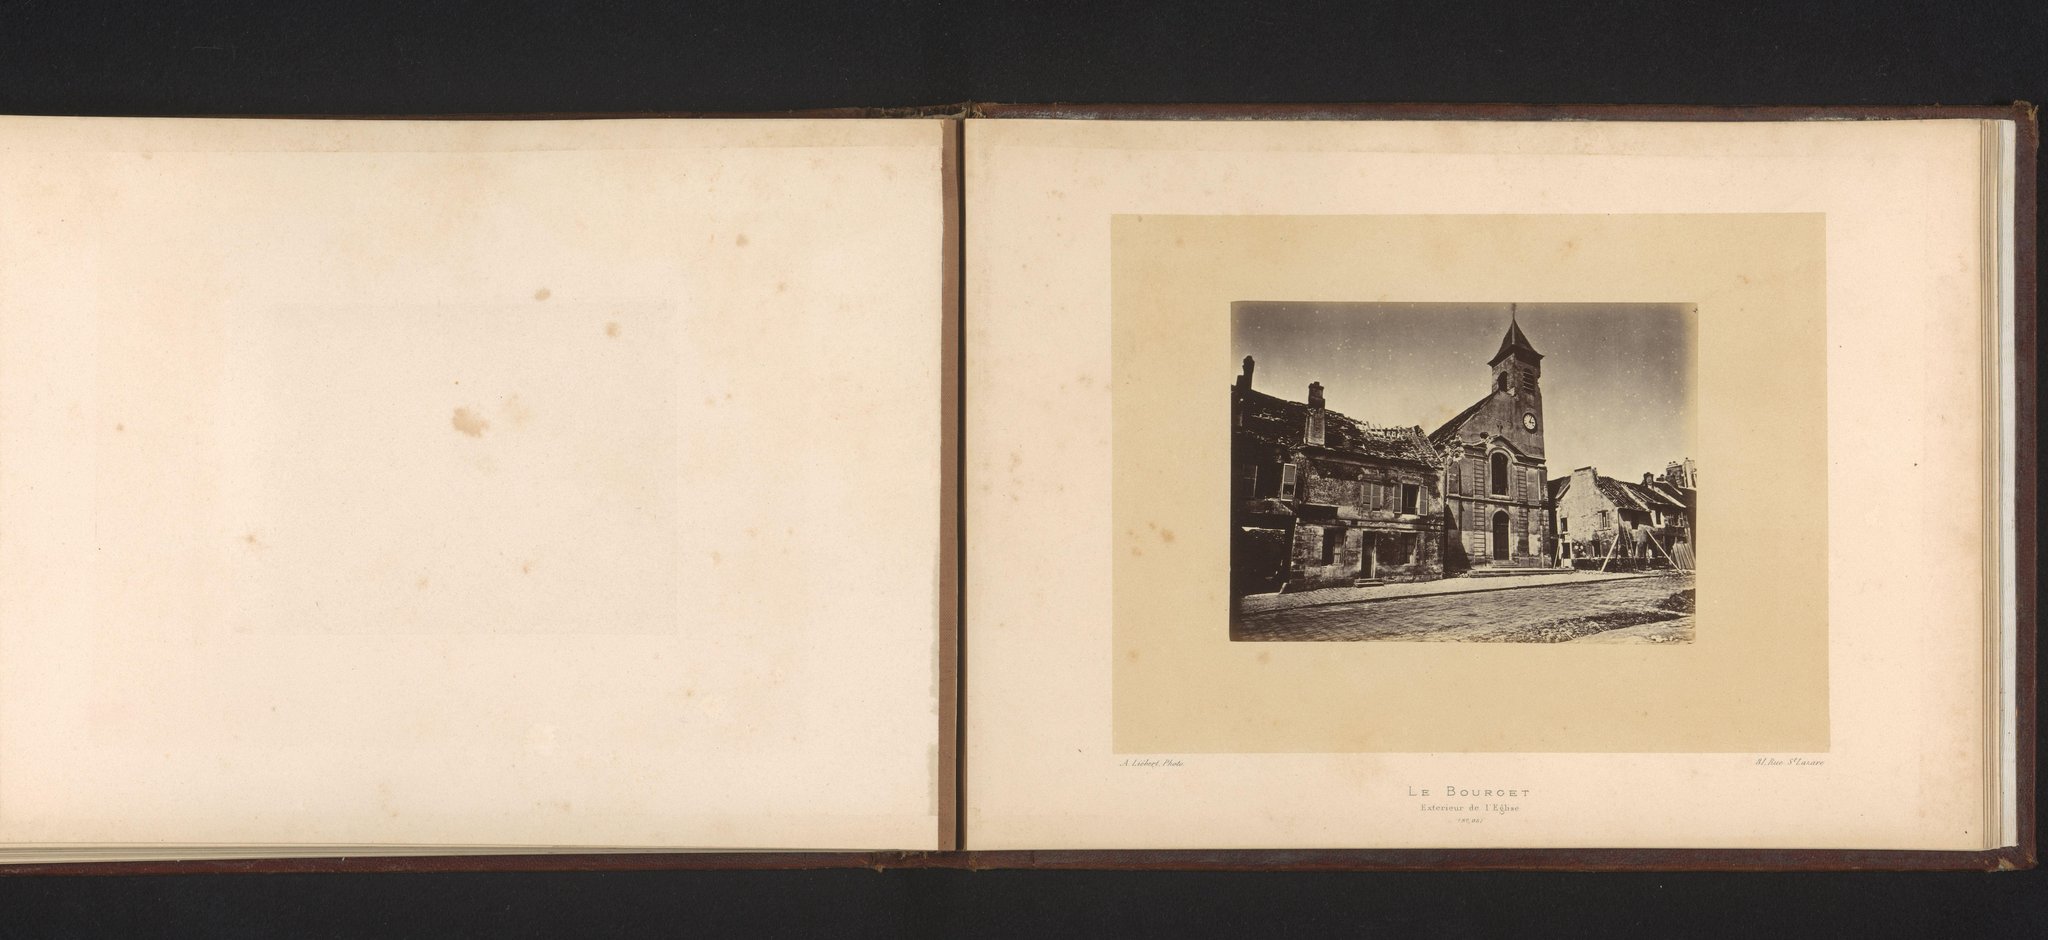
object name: photograph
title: Le Bourget. Exterieur de l'Eglise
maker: alphonse-justin liébert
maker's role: fotograaf, marinier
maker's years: 1827-1914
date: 1871-1872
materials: photographic support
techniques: albumen print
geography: le bourget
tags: ruin of church, monastery, etc.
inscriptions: number: ‘(No. 95)’, address: ‘31, Rue St. Lazare’